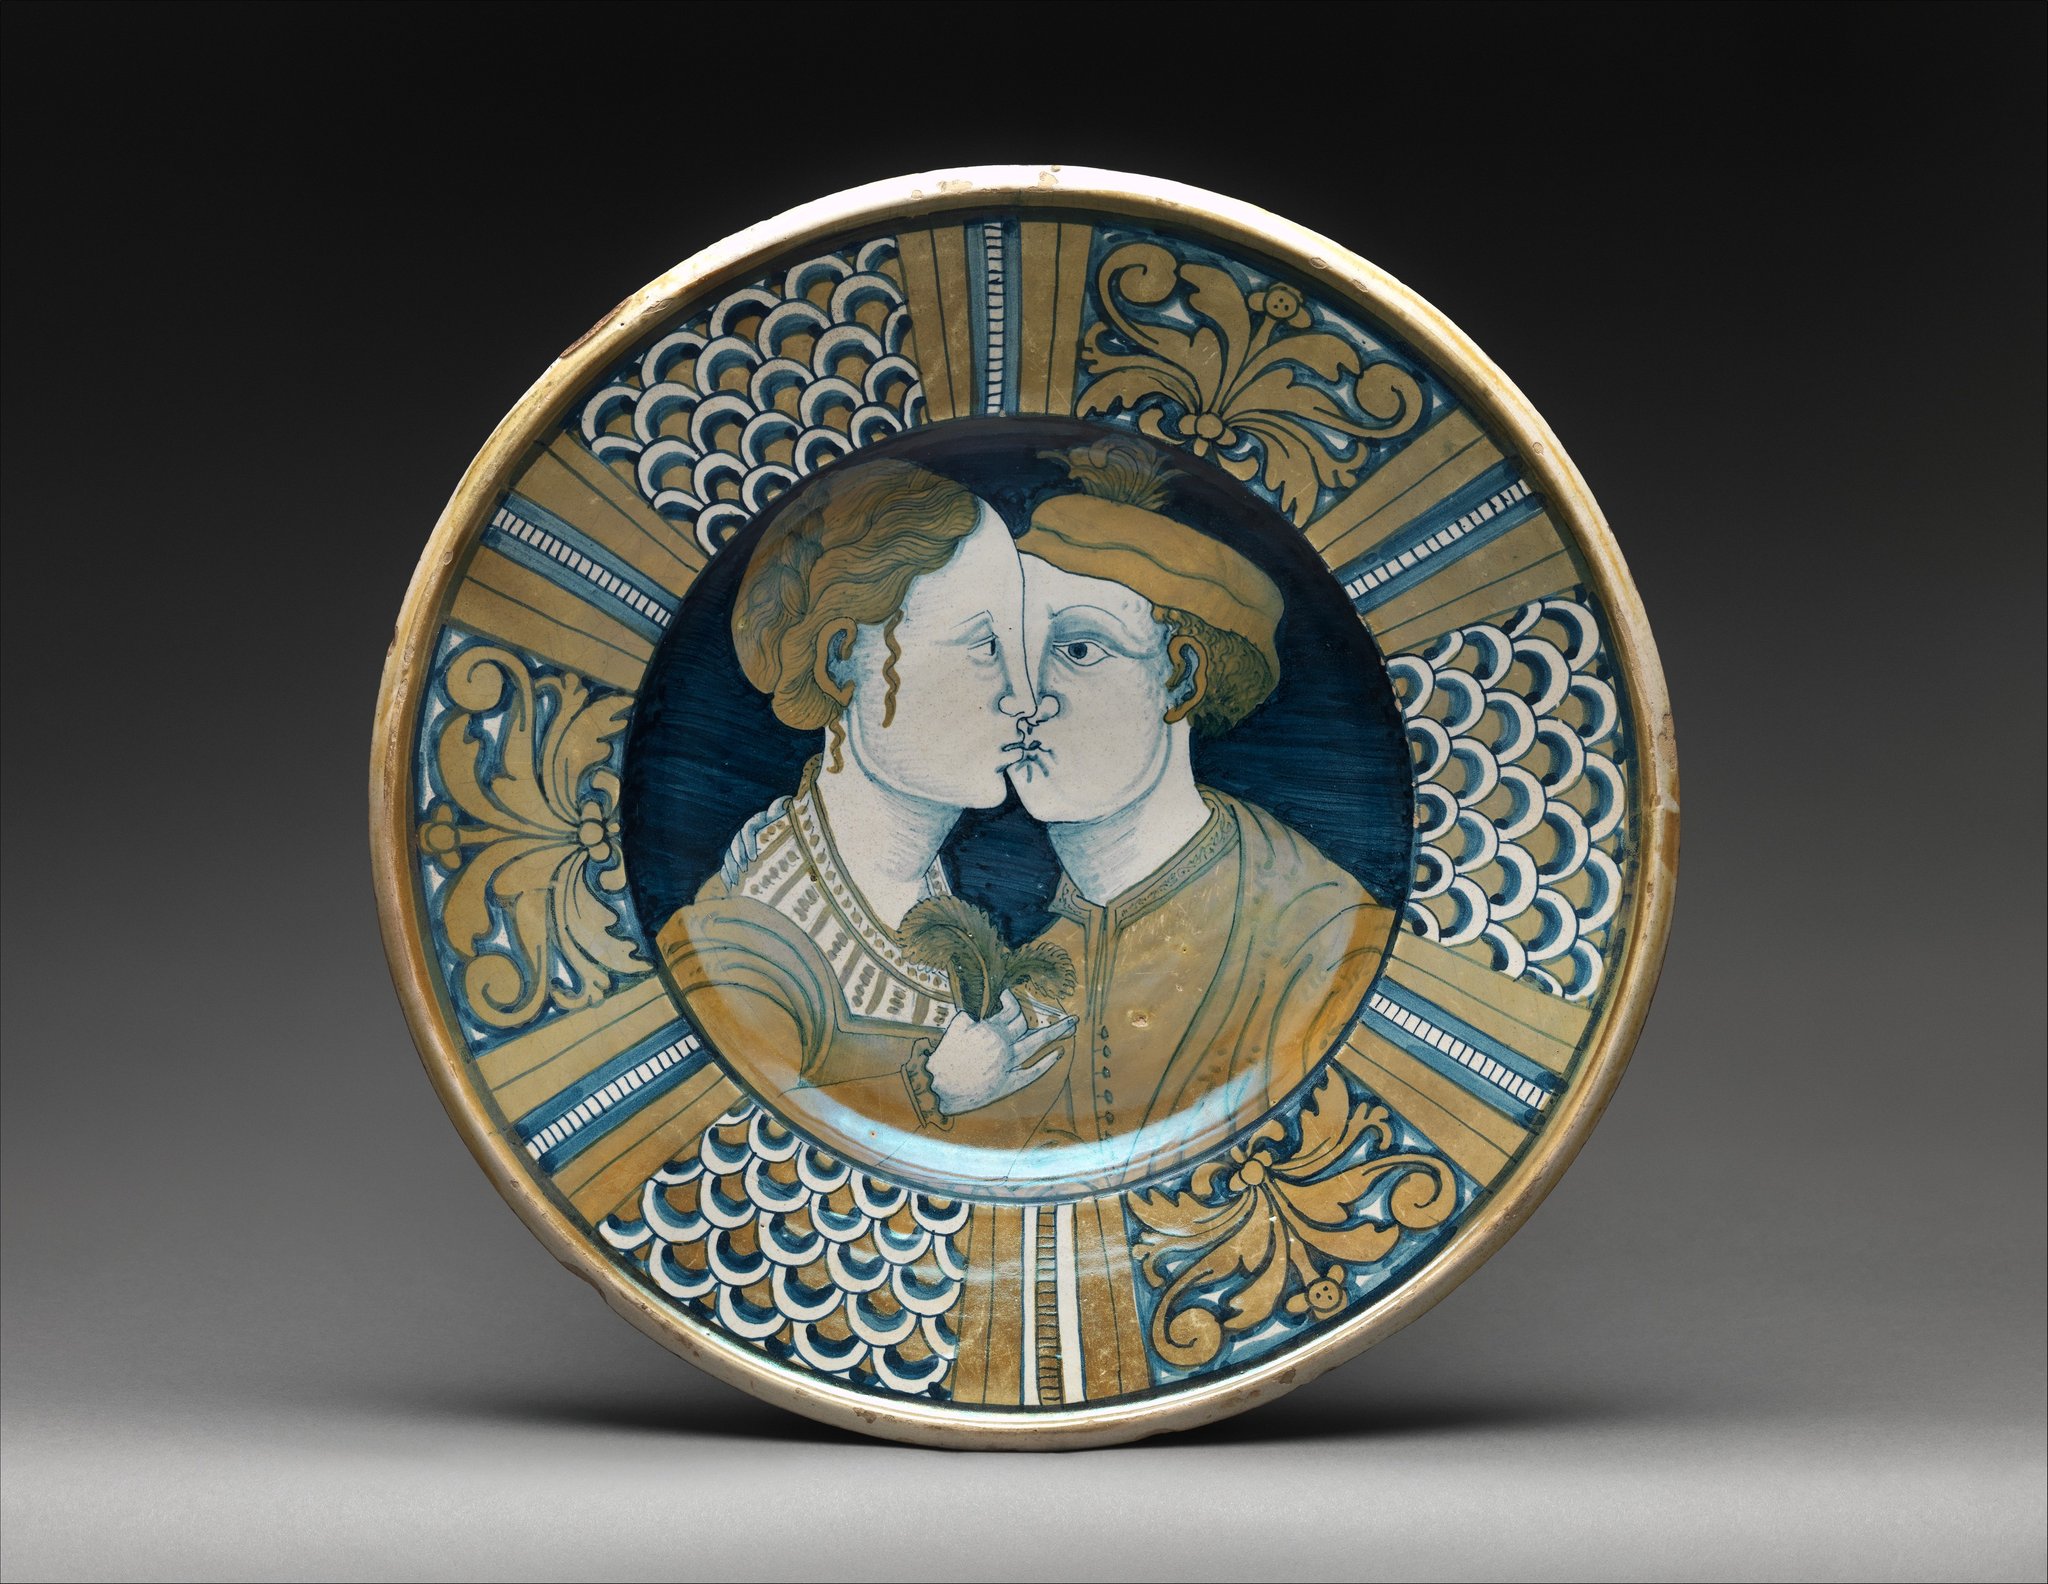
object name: dish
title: Dish with two lovers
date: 1520-1550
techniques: maiolica, glazing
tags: couples,men,women